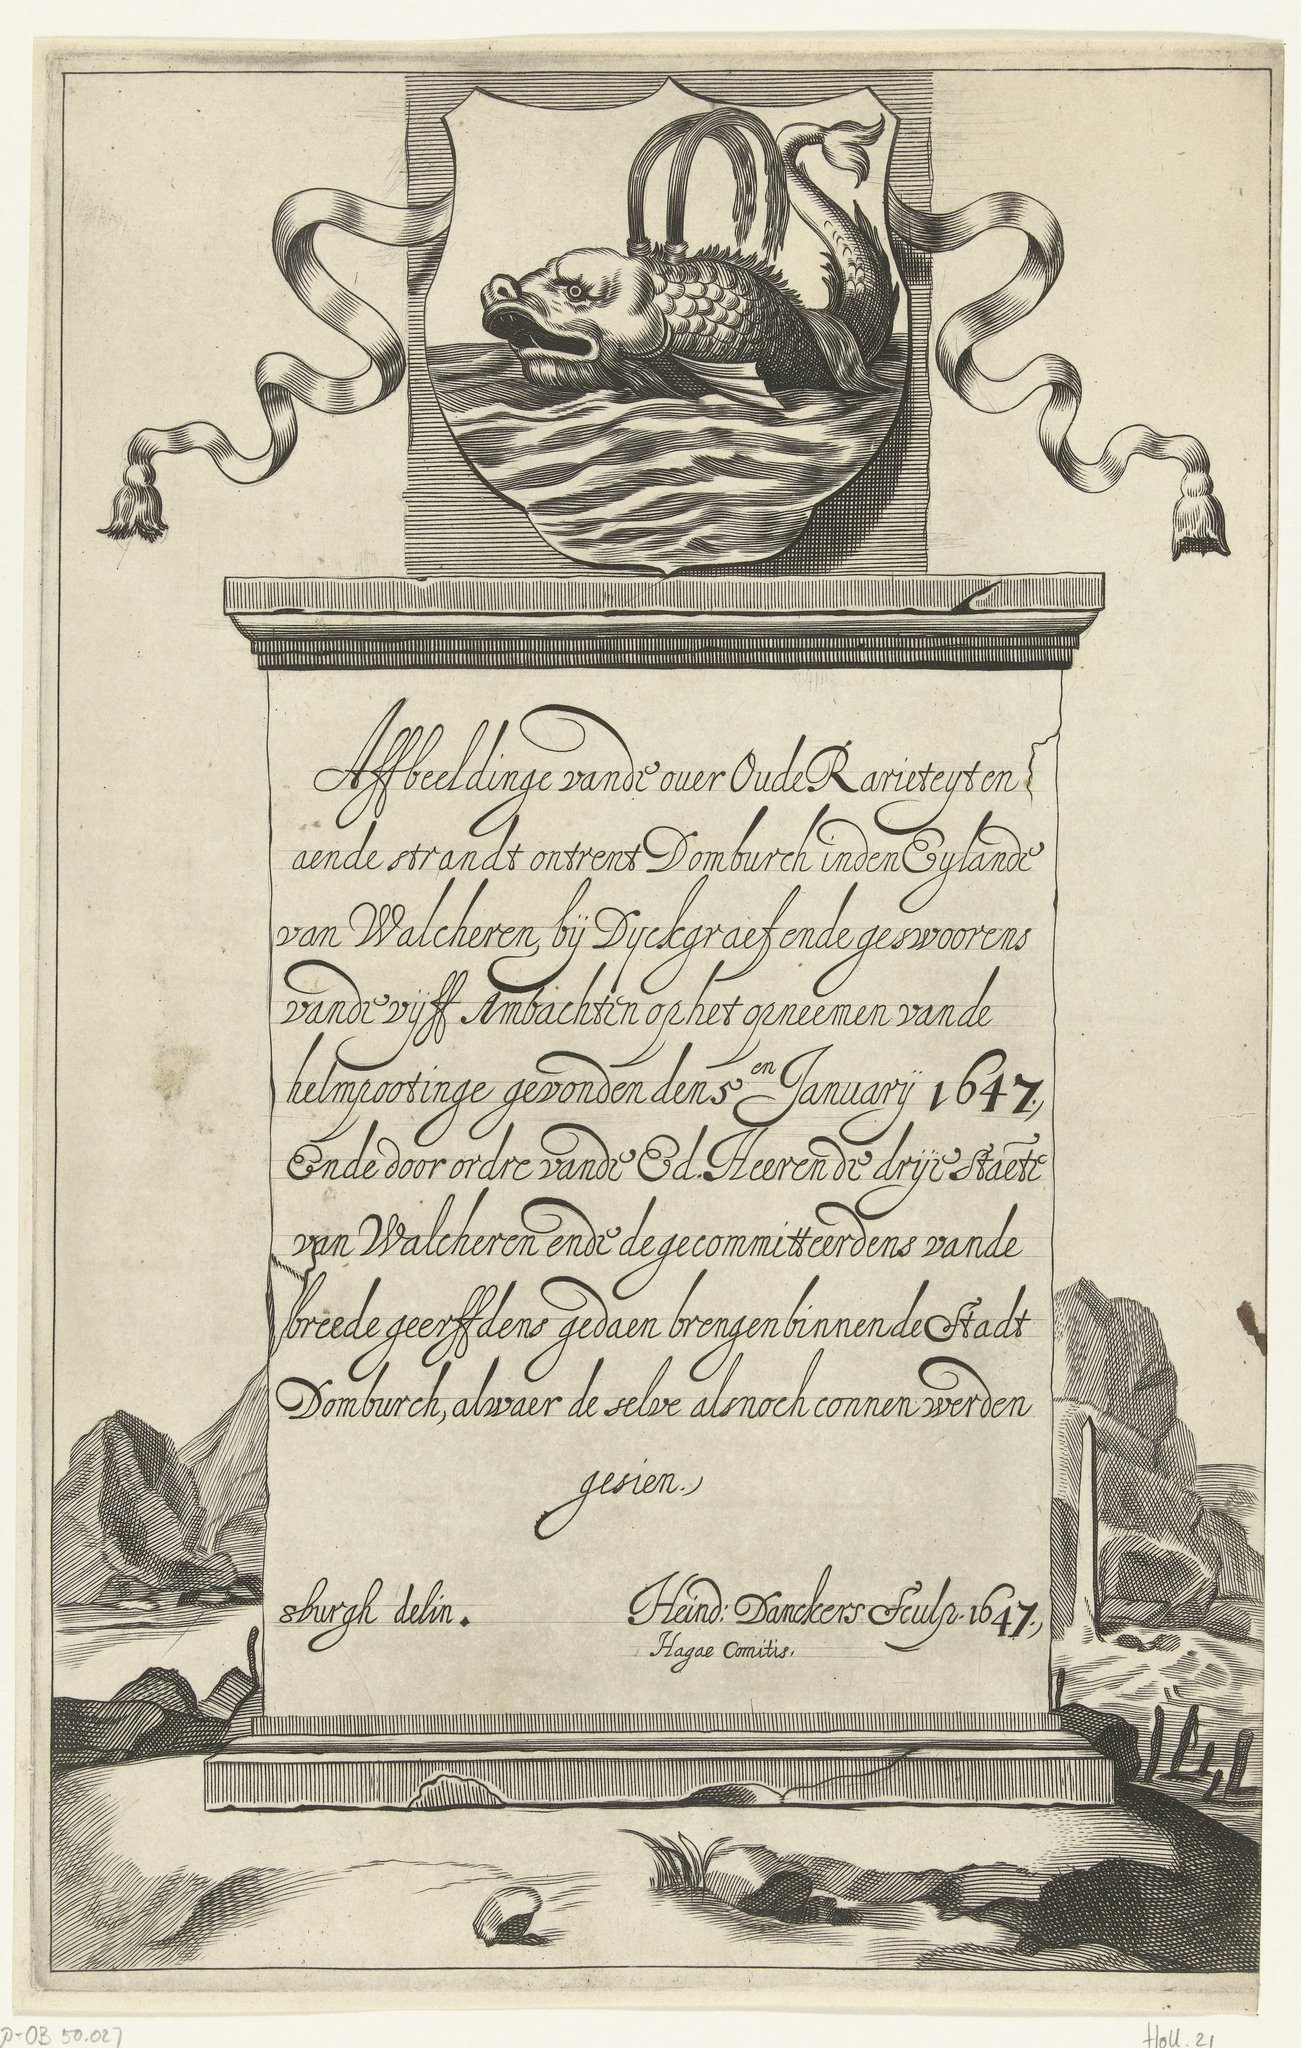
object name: historical object representation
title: Titelprent voor de serie oudheden gevonden op het strand van Walcheren in 1647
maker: hendrick danckerts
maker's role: print maker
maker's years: 1625-1679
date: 1647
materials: paper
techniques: engraving, etching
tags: walcheren, romeinse periode in nederland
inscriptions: date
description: Altaar met het wapen van Walcheren en de titel van de serie.